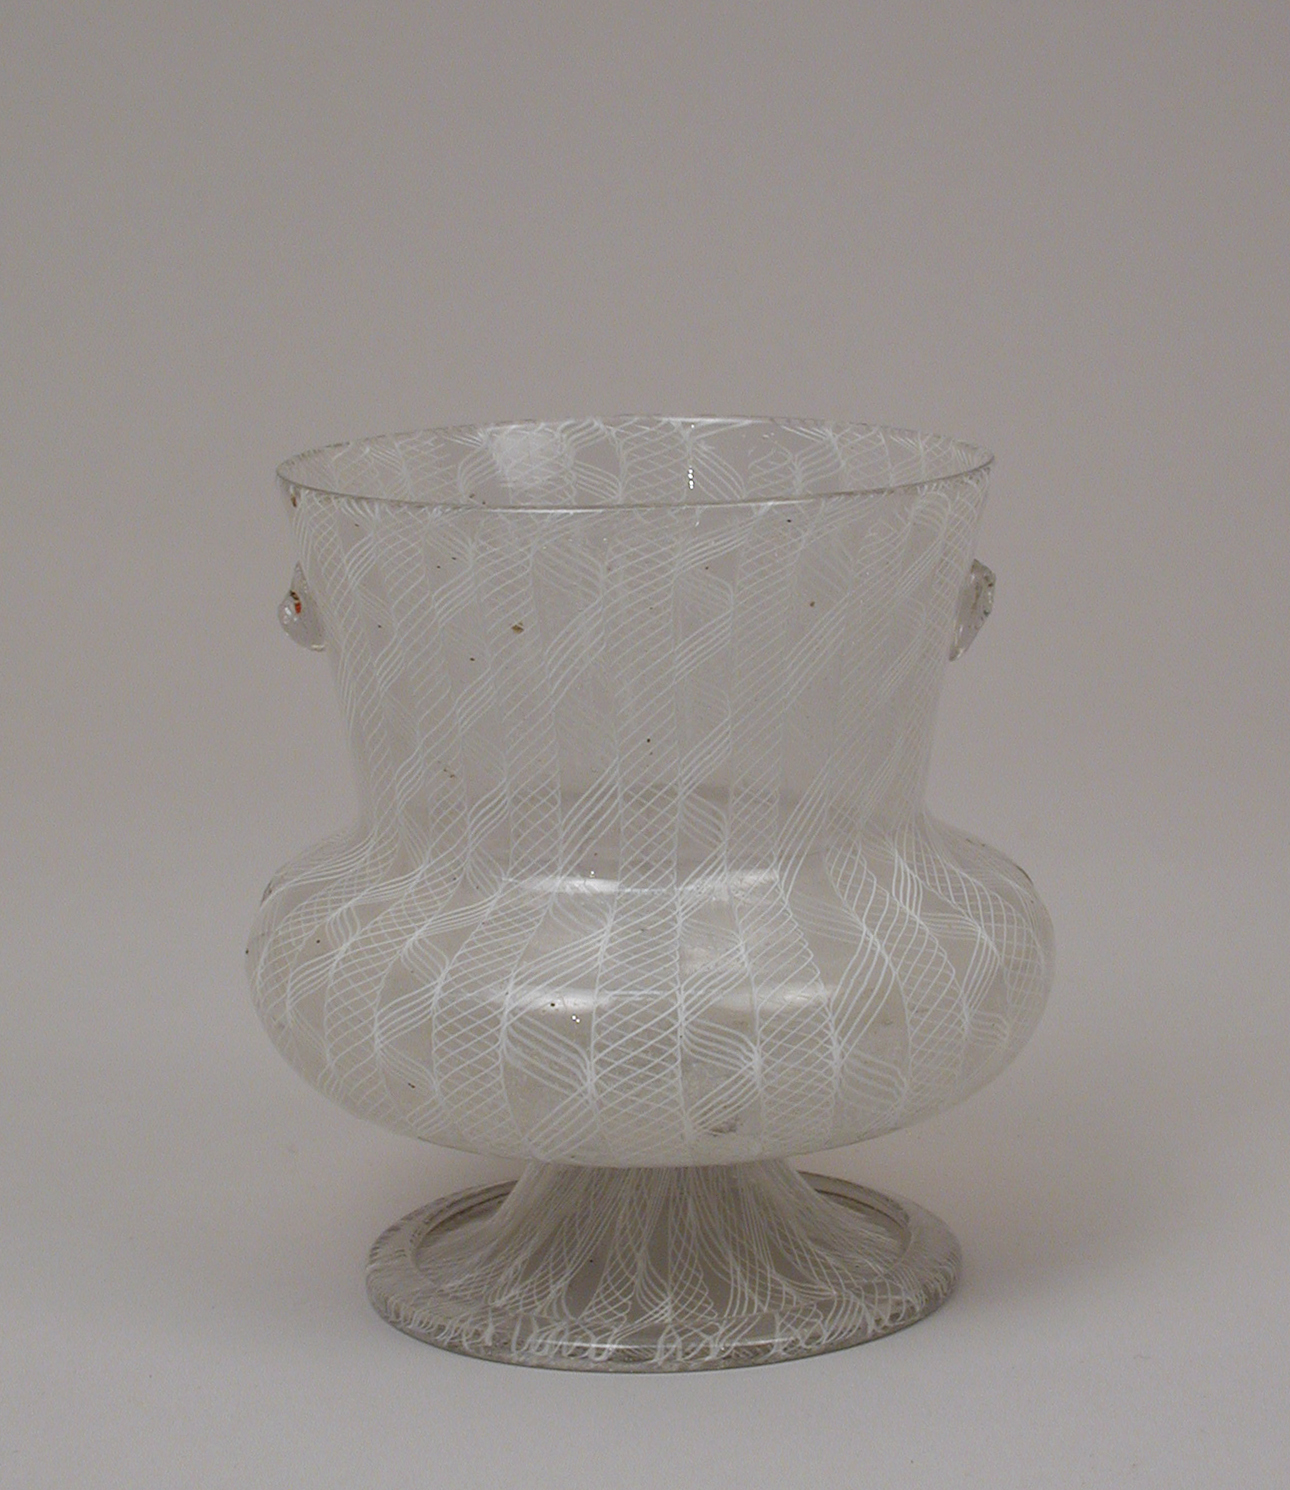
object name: vase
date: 1701-1900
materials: glass